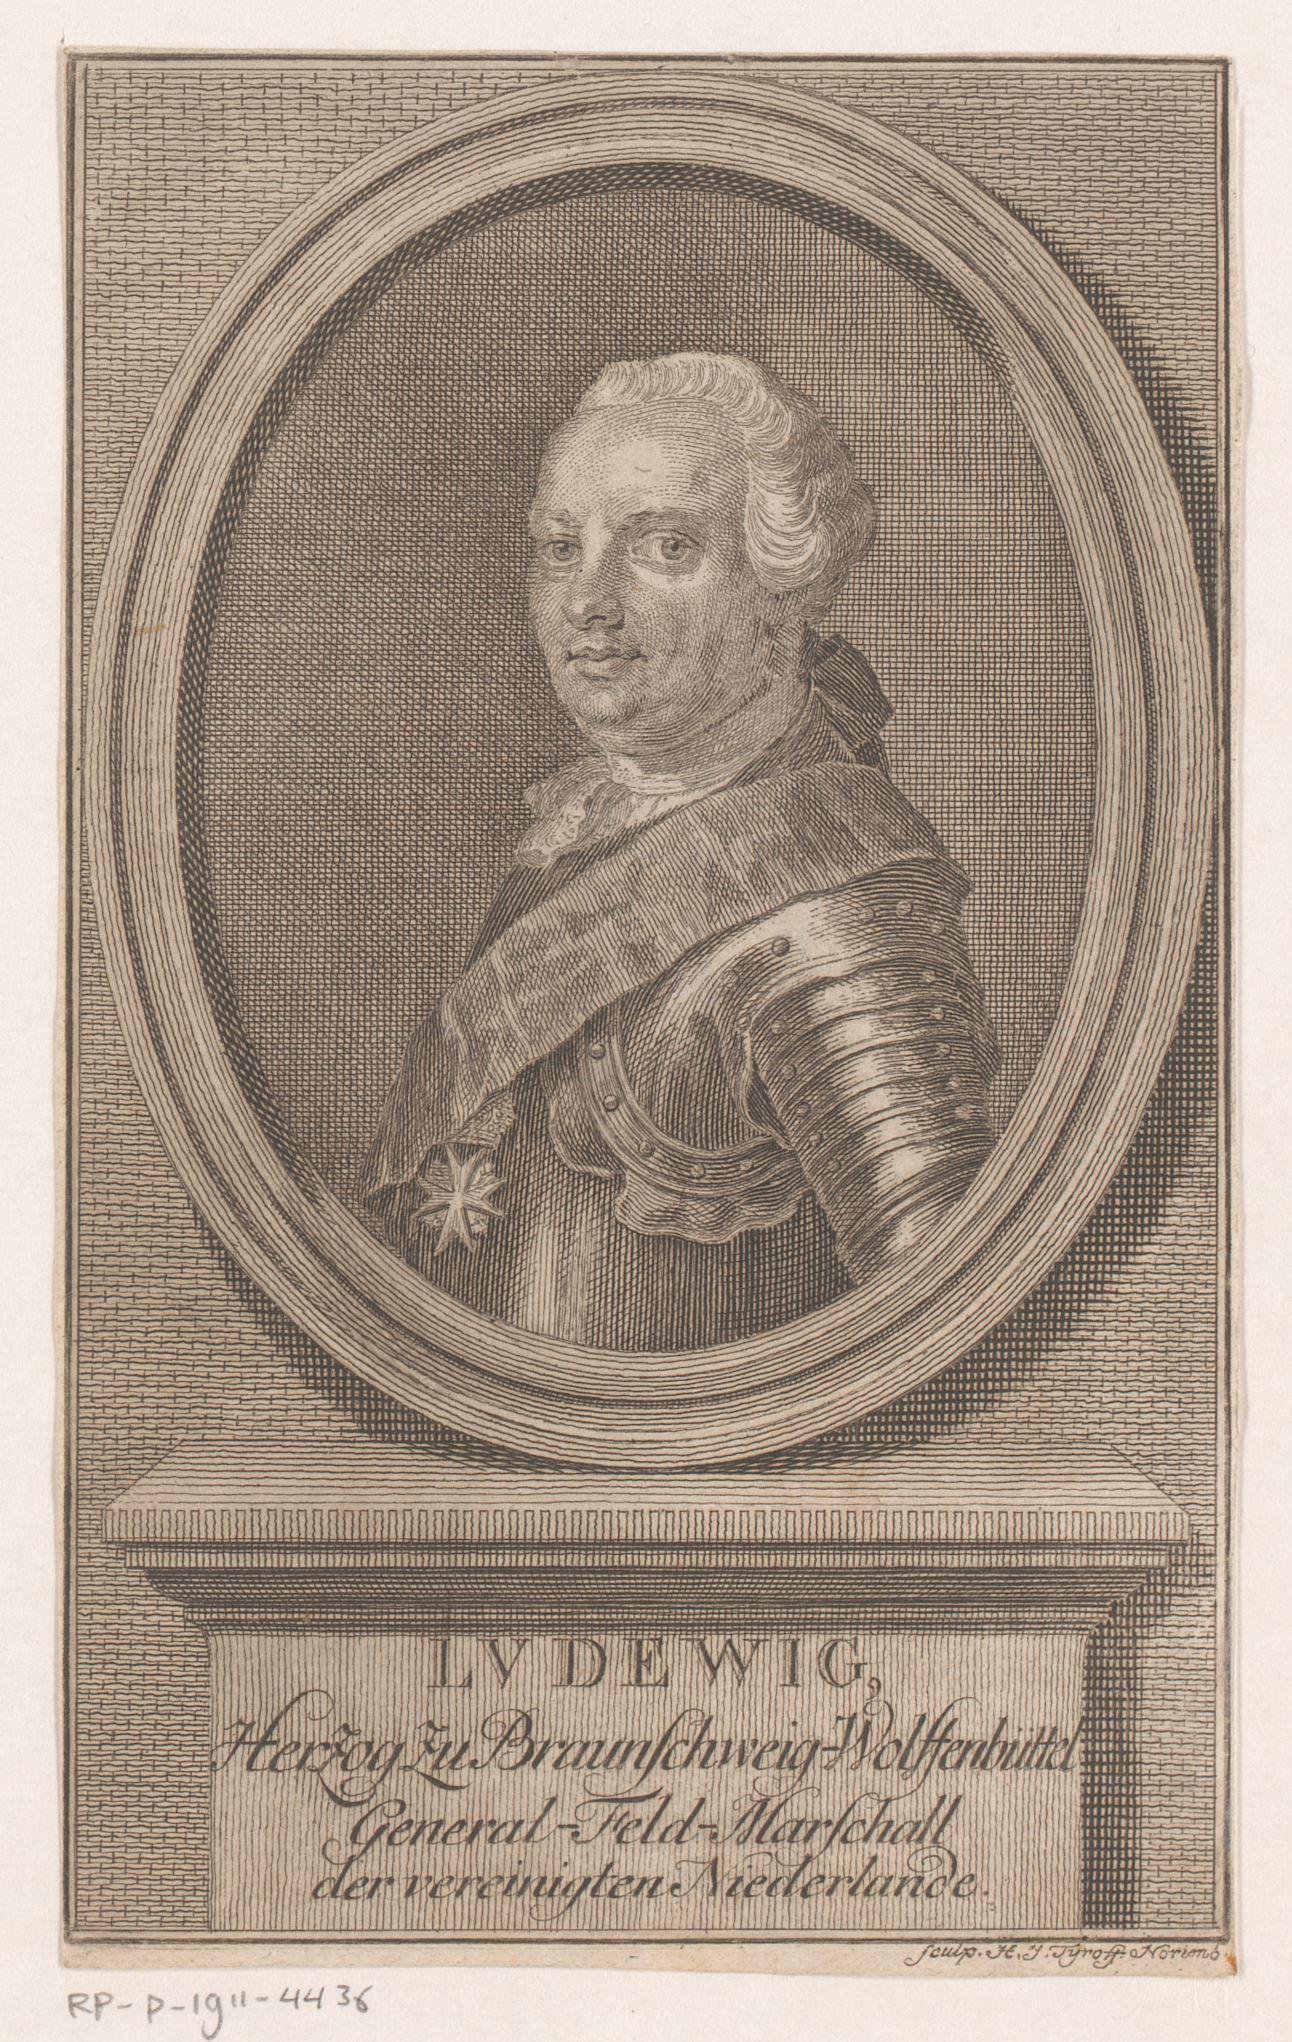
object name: print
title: Portret van Ludwig Ernst von Braunschweig-Wolfenbüttel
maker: hermann jakob tyroff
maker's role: print maker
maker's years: 1742-1809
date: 1752-1798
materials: paper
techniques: etching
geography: nuremberg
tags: ludwig ernst von braunschweig-wolfenbüttel, armour, historical persons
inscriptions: collector's mark: Lugt 2228